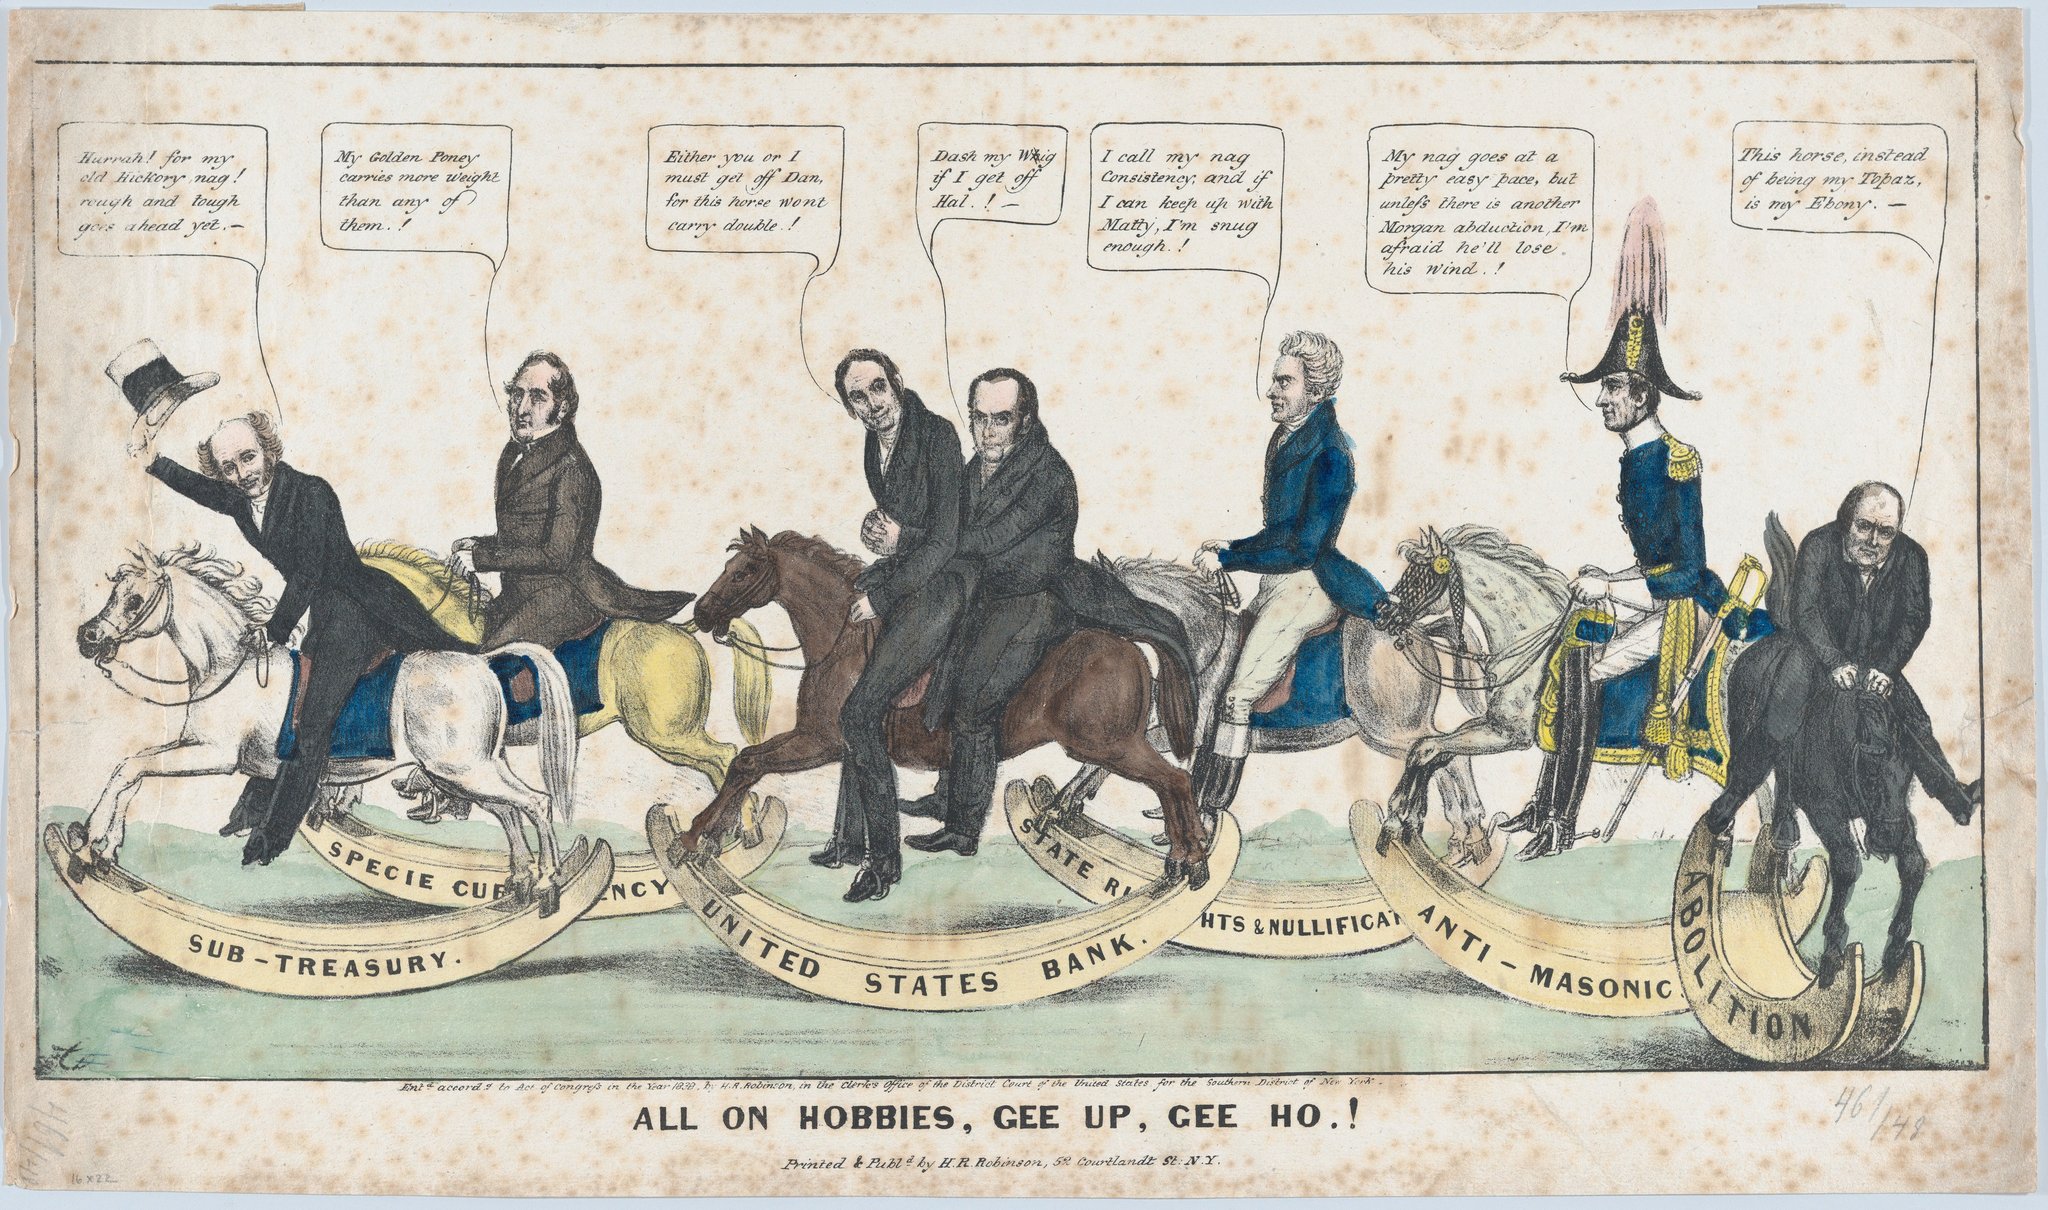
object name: print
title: All on Hobbies, Gee Up, Gee Ho!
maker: edward williams clay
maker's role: artist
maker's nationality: american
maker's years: 1799-1857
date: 1838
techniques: hand coloring, lithograph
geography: new york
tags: satire,men,horses,politics